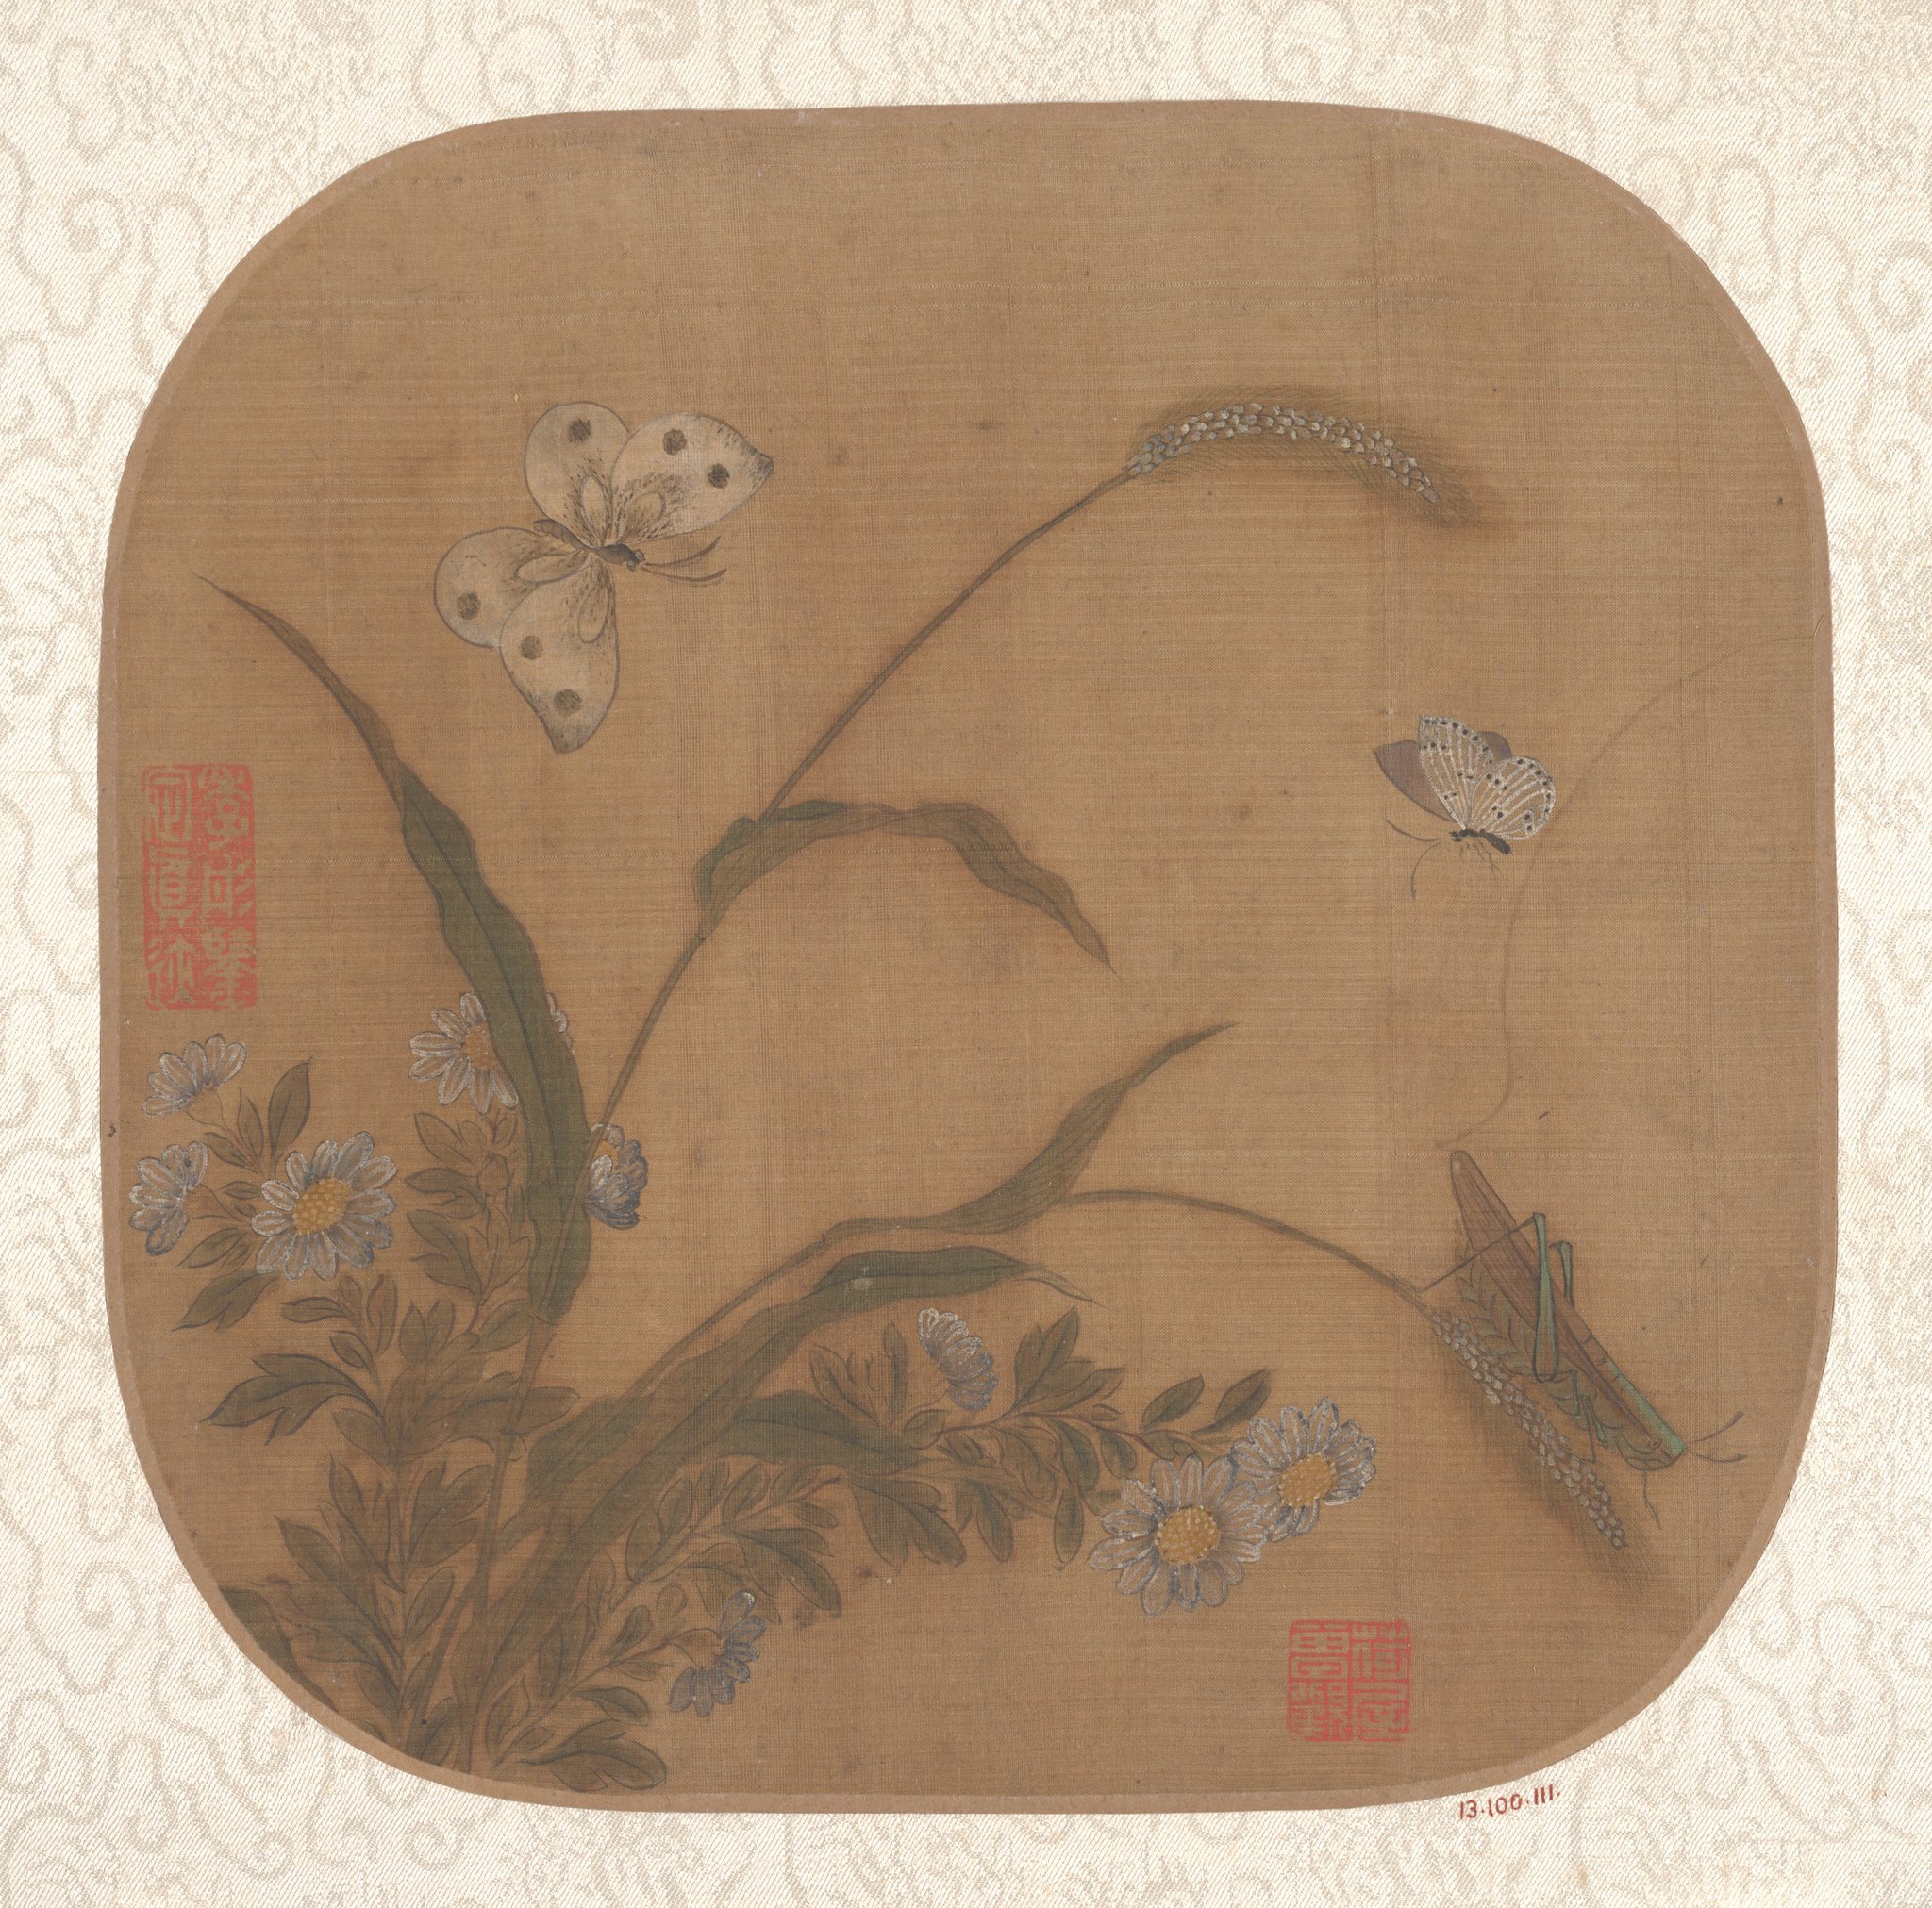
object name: fan mounted a an album leaf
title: Autumn Splendor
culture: chinese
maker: gong jufi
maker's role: artist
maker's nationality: chinese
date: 1271-1368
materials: ink, silk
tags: butterflies,flowers